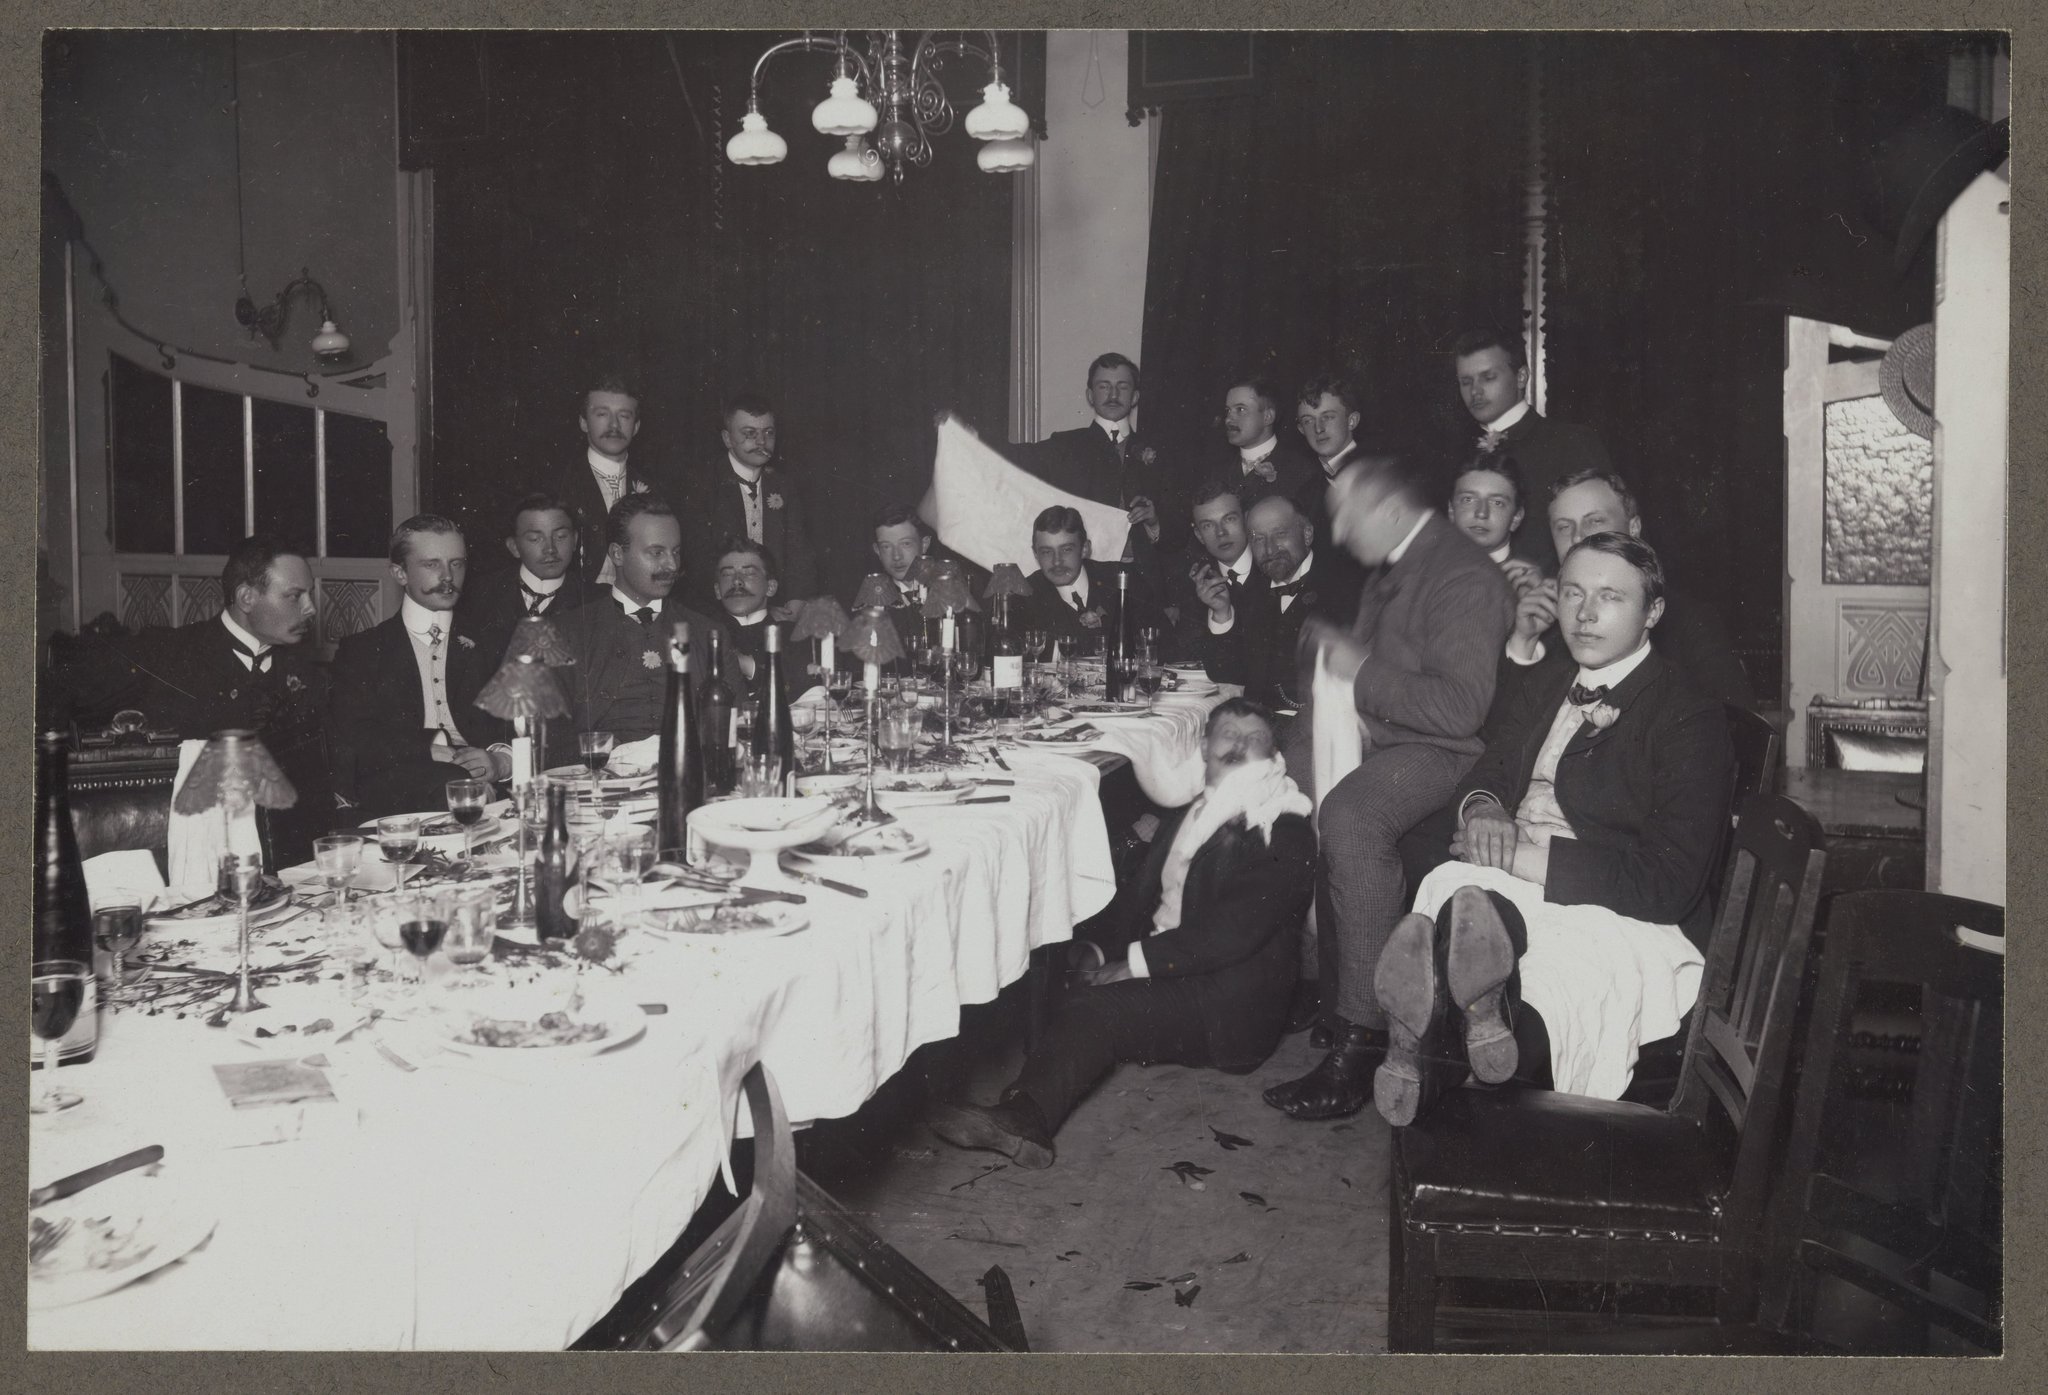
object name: photograph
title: Groepsportret van studenten aan een gedekte tafel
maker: Anonymous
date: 1907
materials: cardboard, photographic support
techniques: gelatin silver print